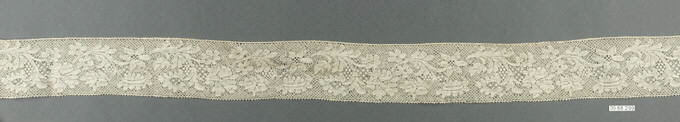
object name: edging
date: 1701-1800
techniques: lace